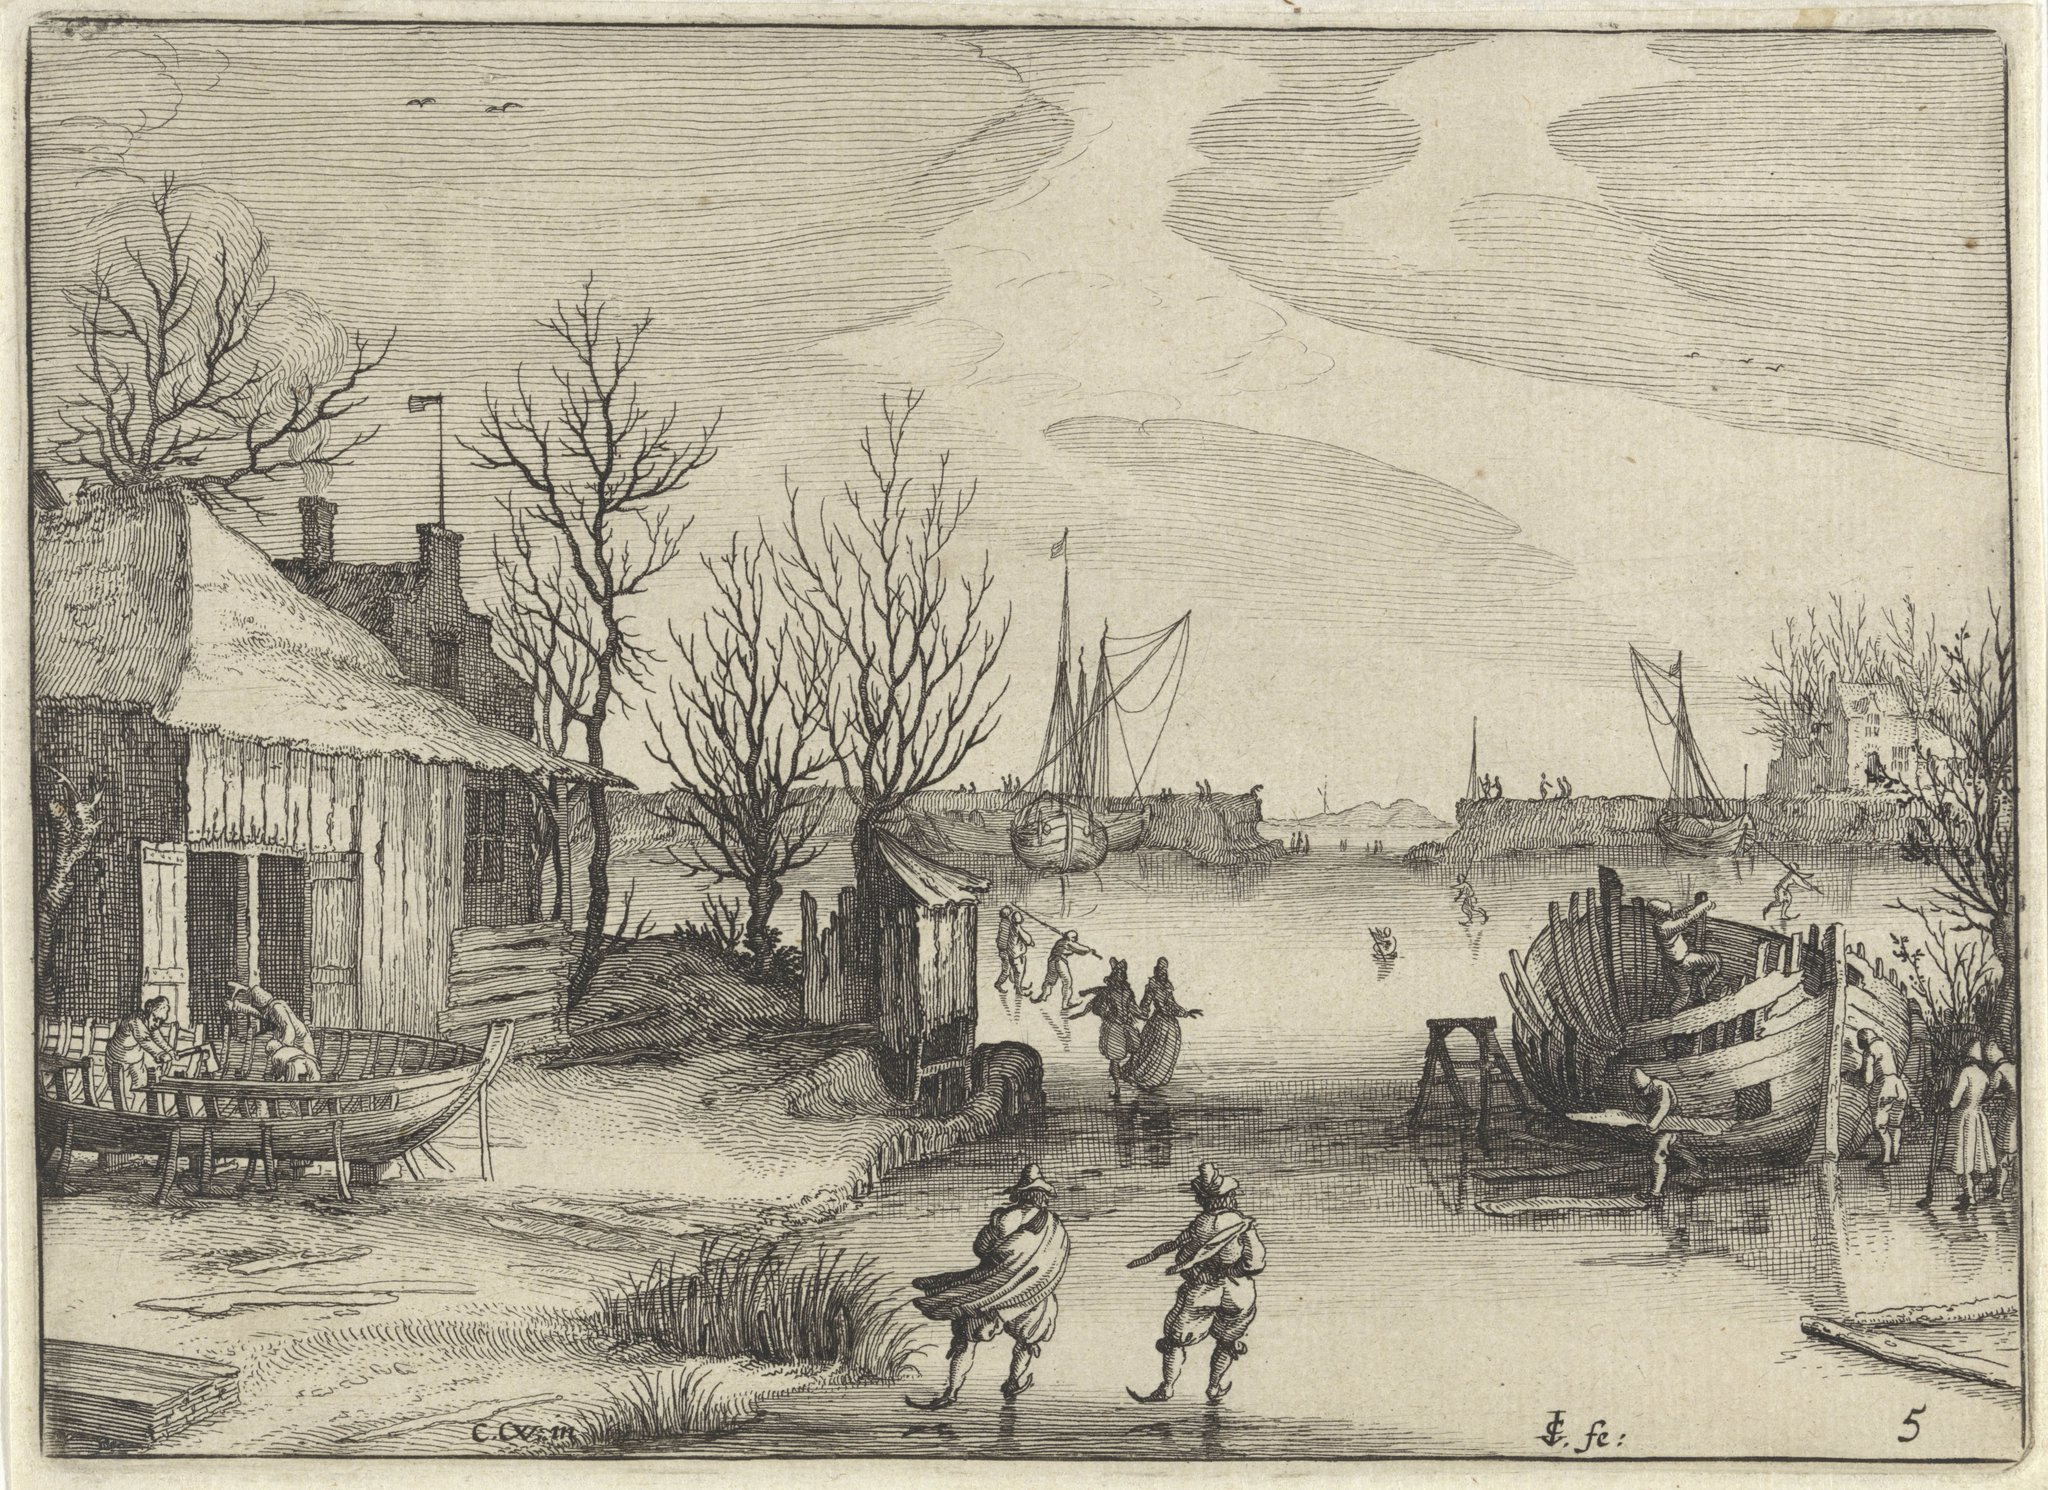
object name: print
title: Scheepswerf aan een bevroren kanaal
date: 1613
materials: paper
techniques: etching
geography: amsterdam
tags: skates (winter sports), pier, quay, wharf, ships, boats on land, beached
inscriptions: collector's mark: Lugt 2228, number: ‘5’, signature: ‘VIC fe:’, signature: ‘C. CW. in’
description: Scheepswerf aan bevroren water. Links de werf, waarvoor twee mannen een boot aan het bouwen zijn. Rechts, op het ijs, een tweede boot waaraan wordt gewerkt. Schaatsers op het ijs.